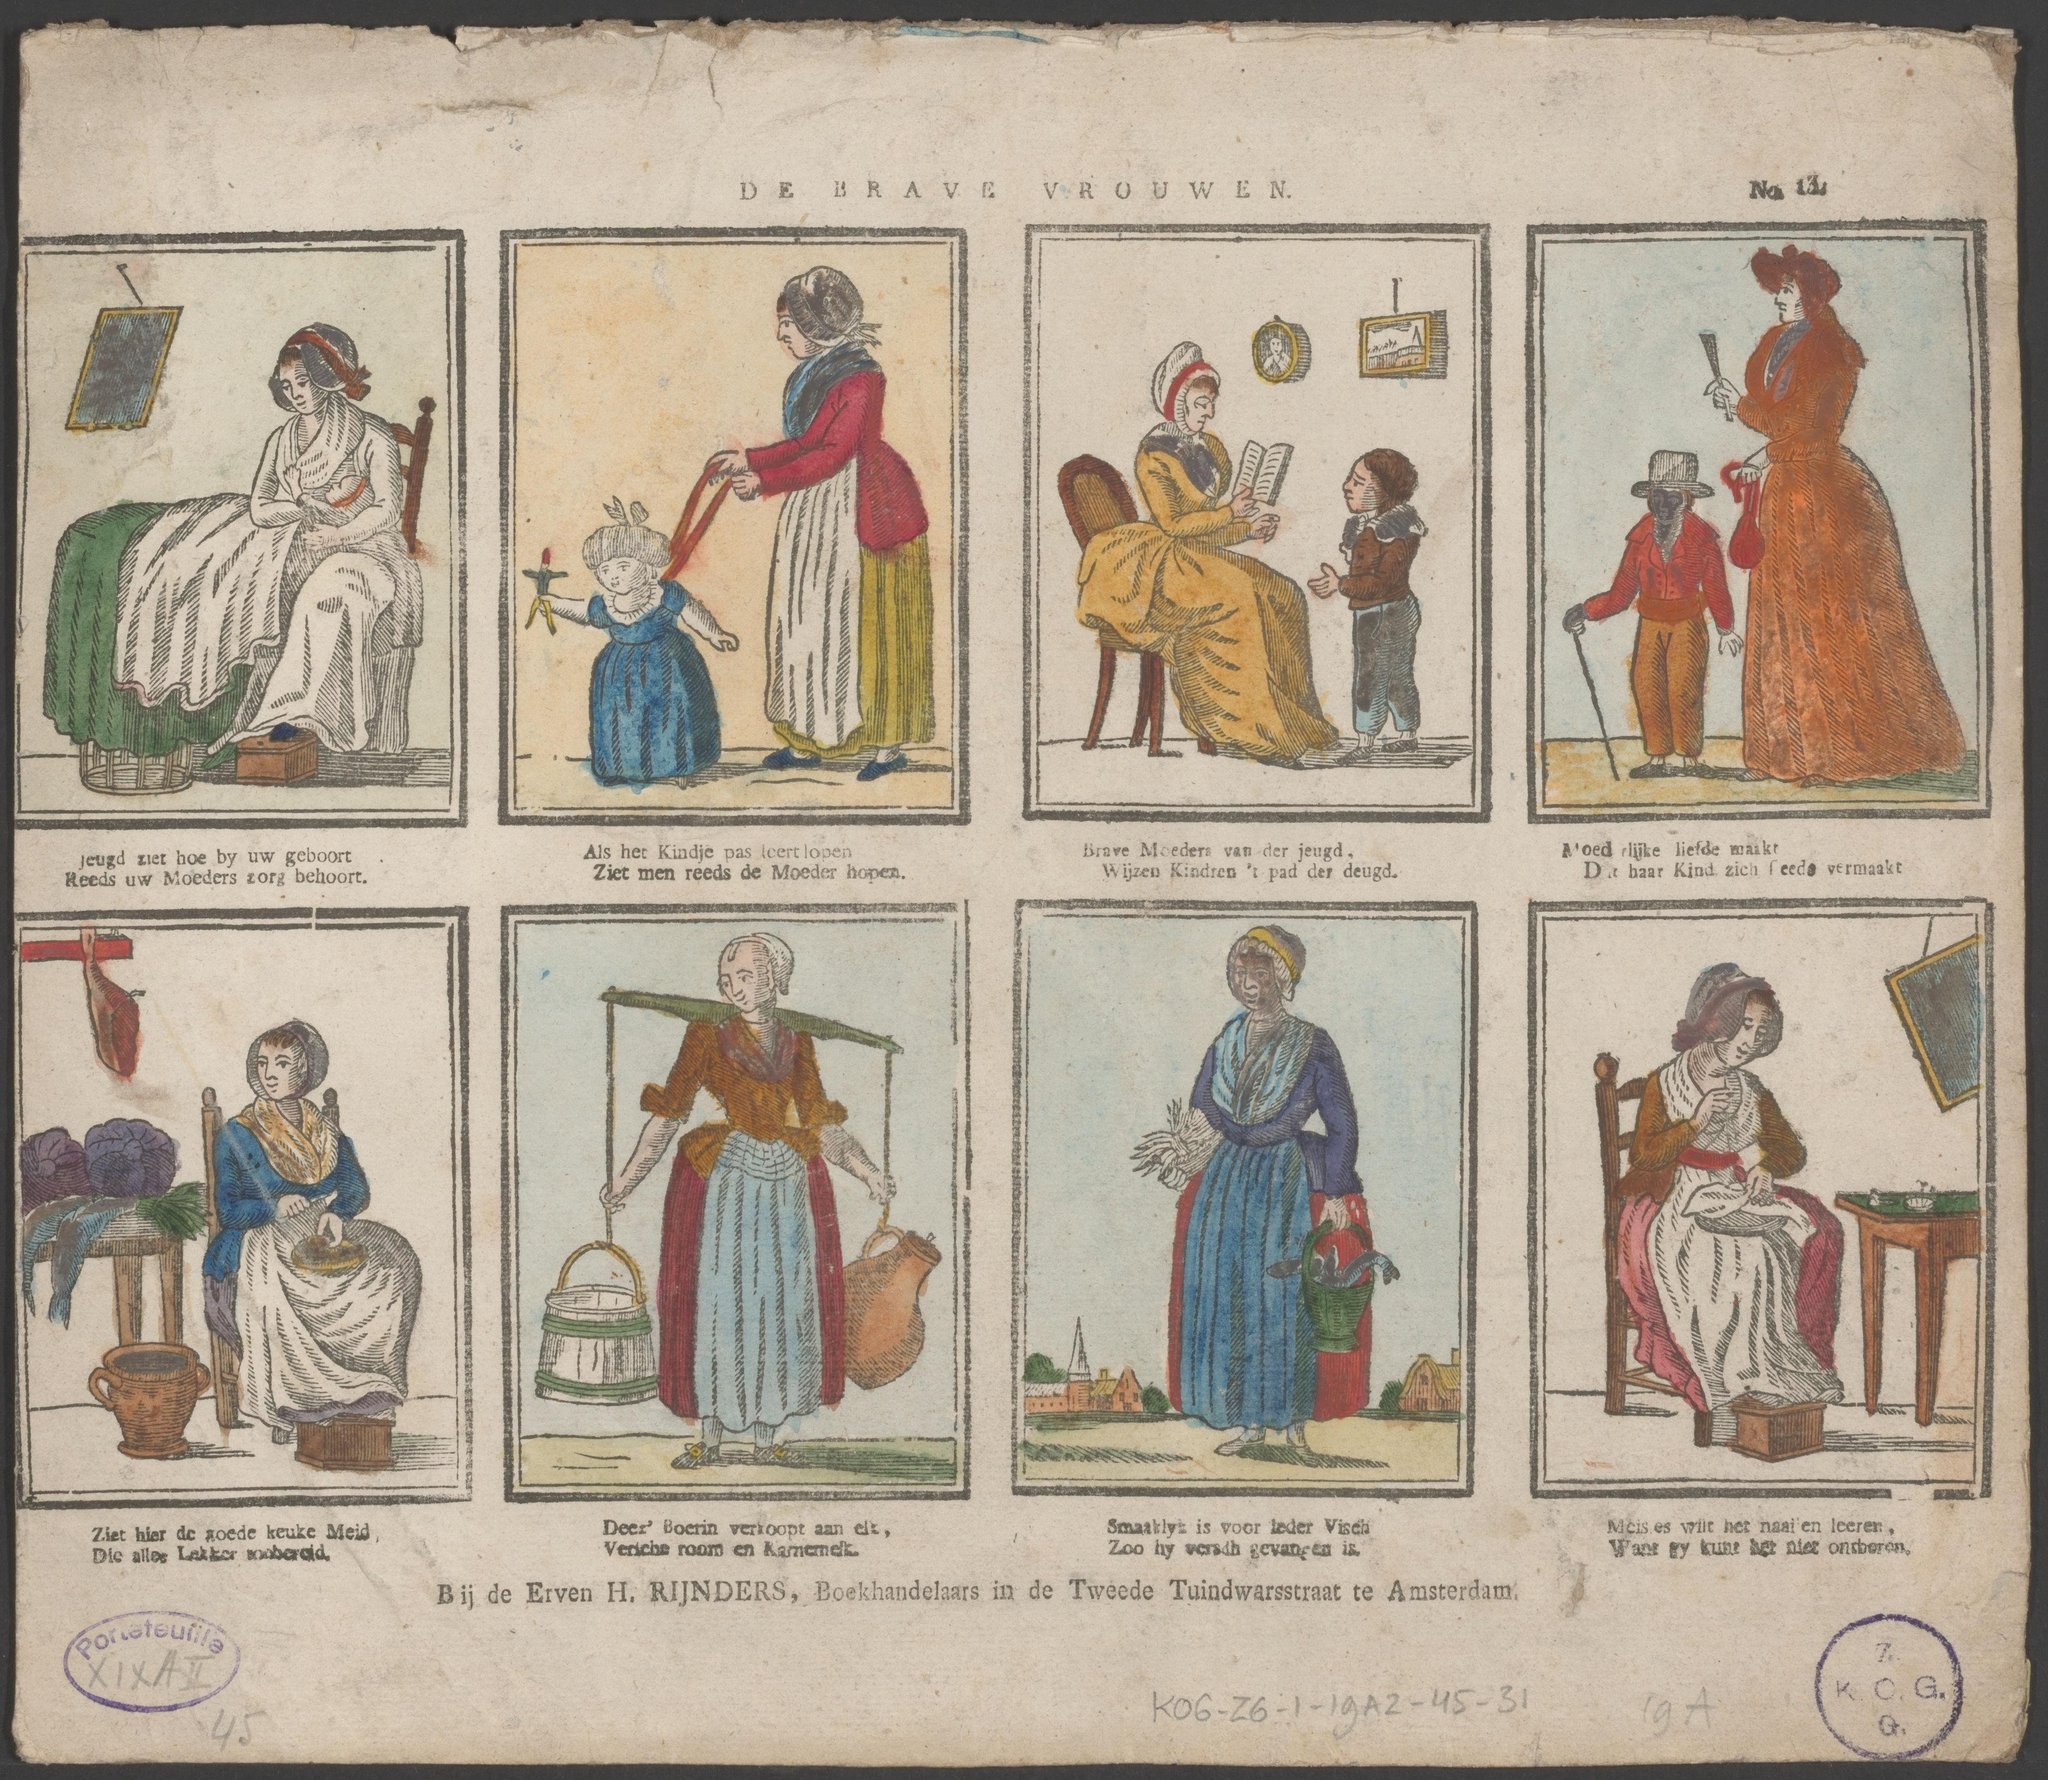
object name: print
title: De brave vrouwen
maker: Anonymous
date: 1831-1854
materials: paper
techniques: hand coloring, letterpress printing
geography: amsterdam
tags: household chores, kitchen-maid, kitchen servant, sewing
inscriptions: collector's mark: Lugt 1641, stamp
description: Blad met acht voorstellingen van vrouwen die huishoudelijke taken uitvoeren, zoals voor de kinderen zorgen en naaien. Onder elke afbeelding een tweeregelig vers. Genummerd rechtsboven: No. 13. Onderwerpsrubrieken binnen de Atlas Zeden en Gewoonten: Zeden en gewoonten in engeren zin, Des menschen begin, midden en einde, Kinderprenten opgeplakt op karton.